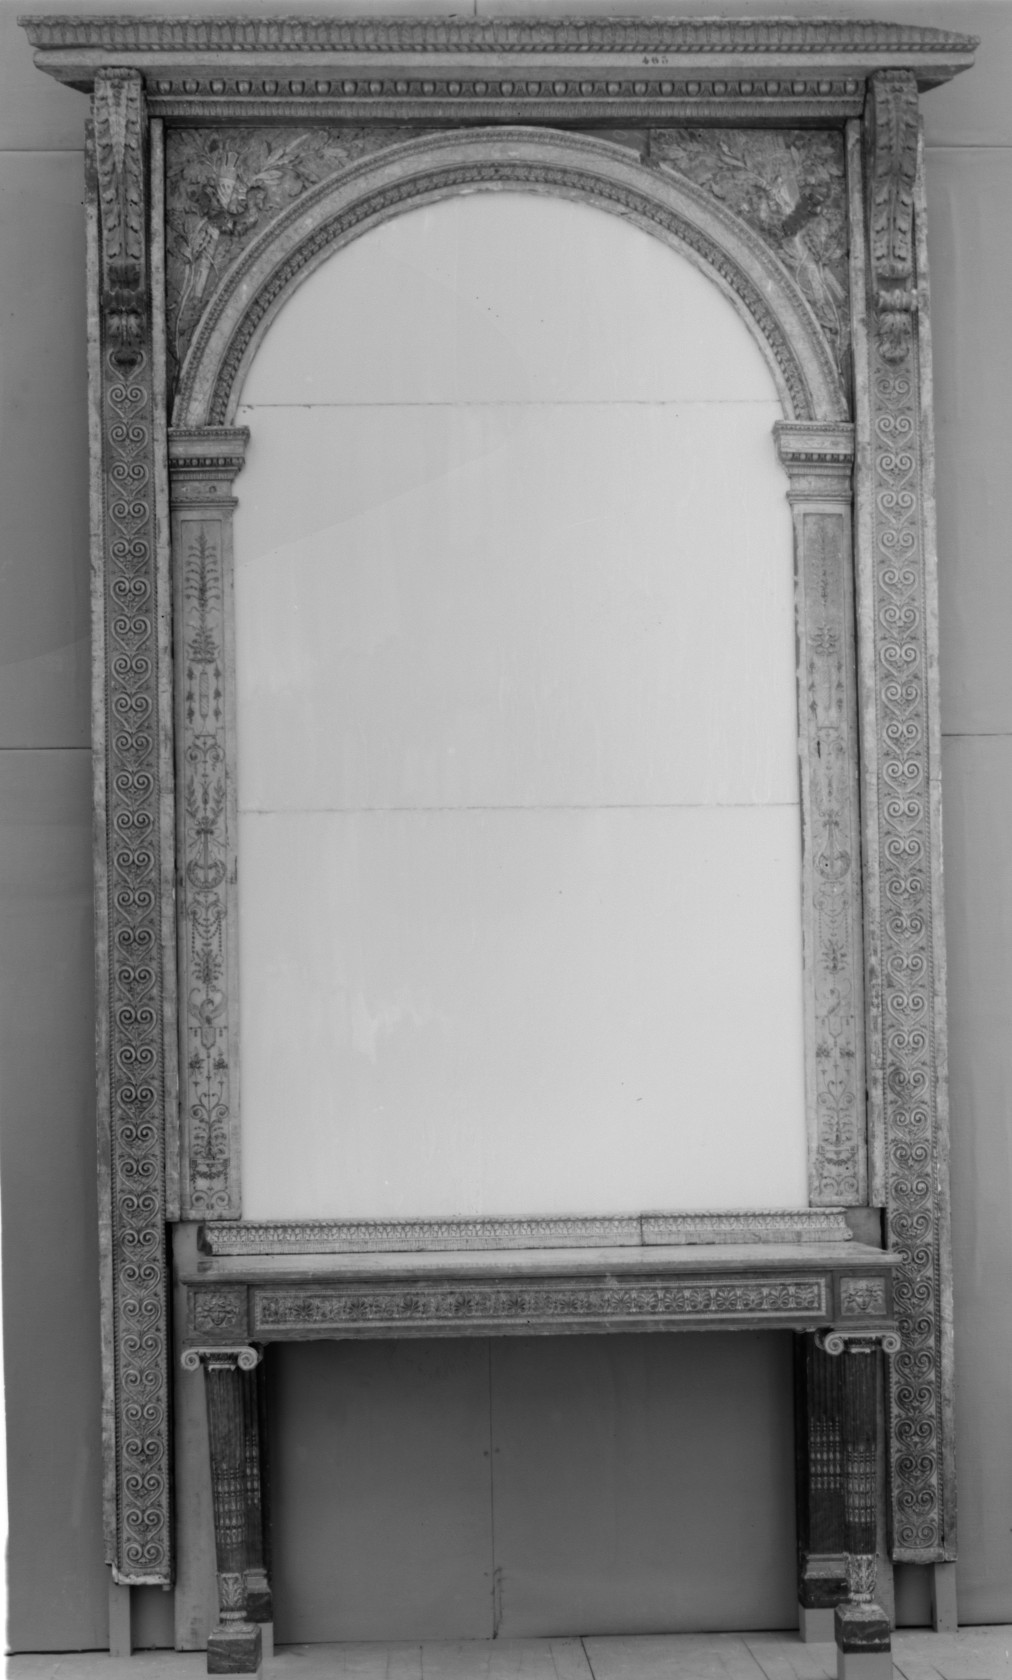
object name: mirror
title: Overmantel mirror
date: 1701-1800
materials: wood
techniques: gilding, painting